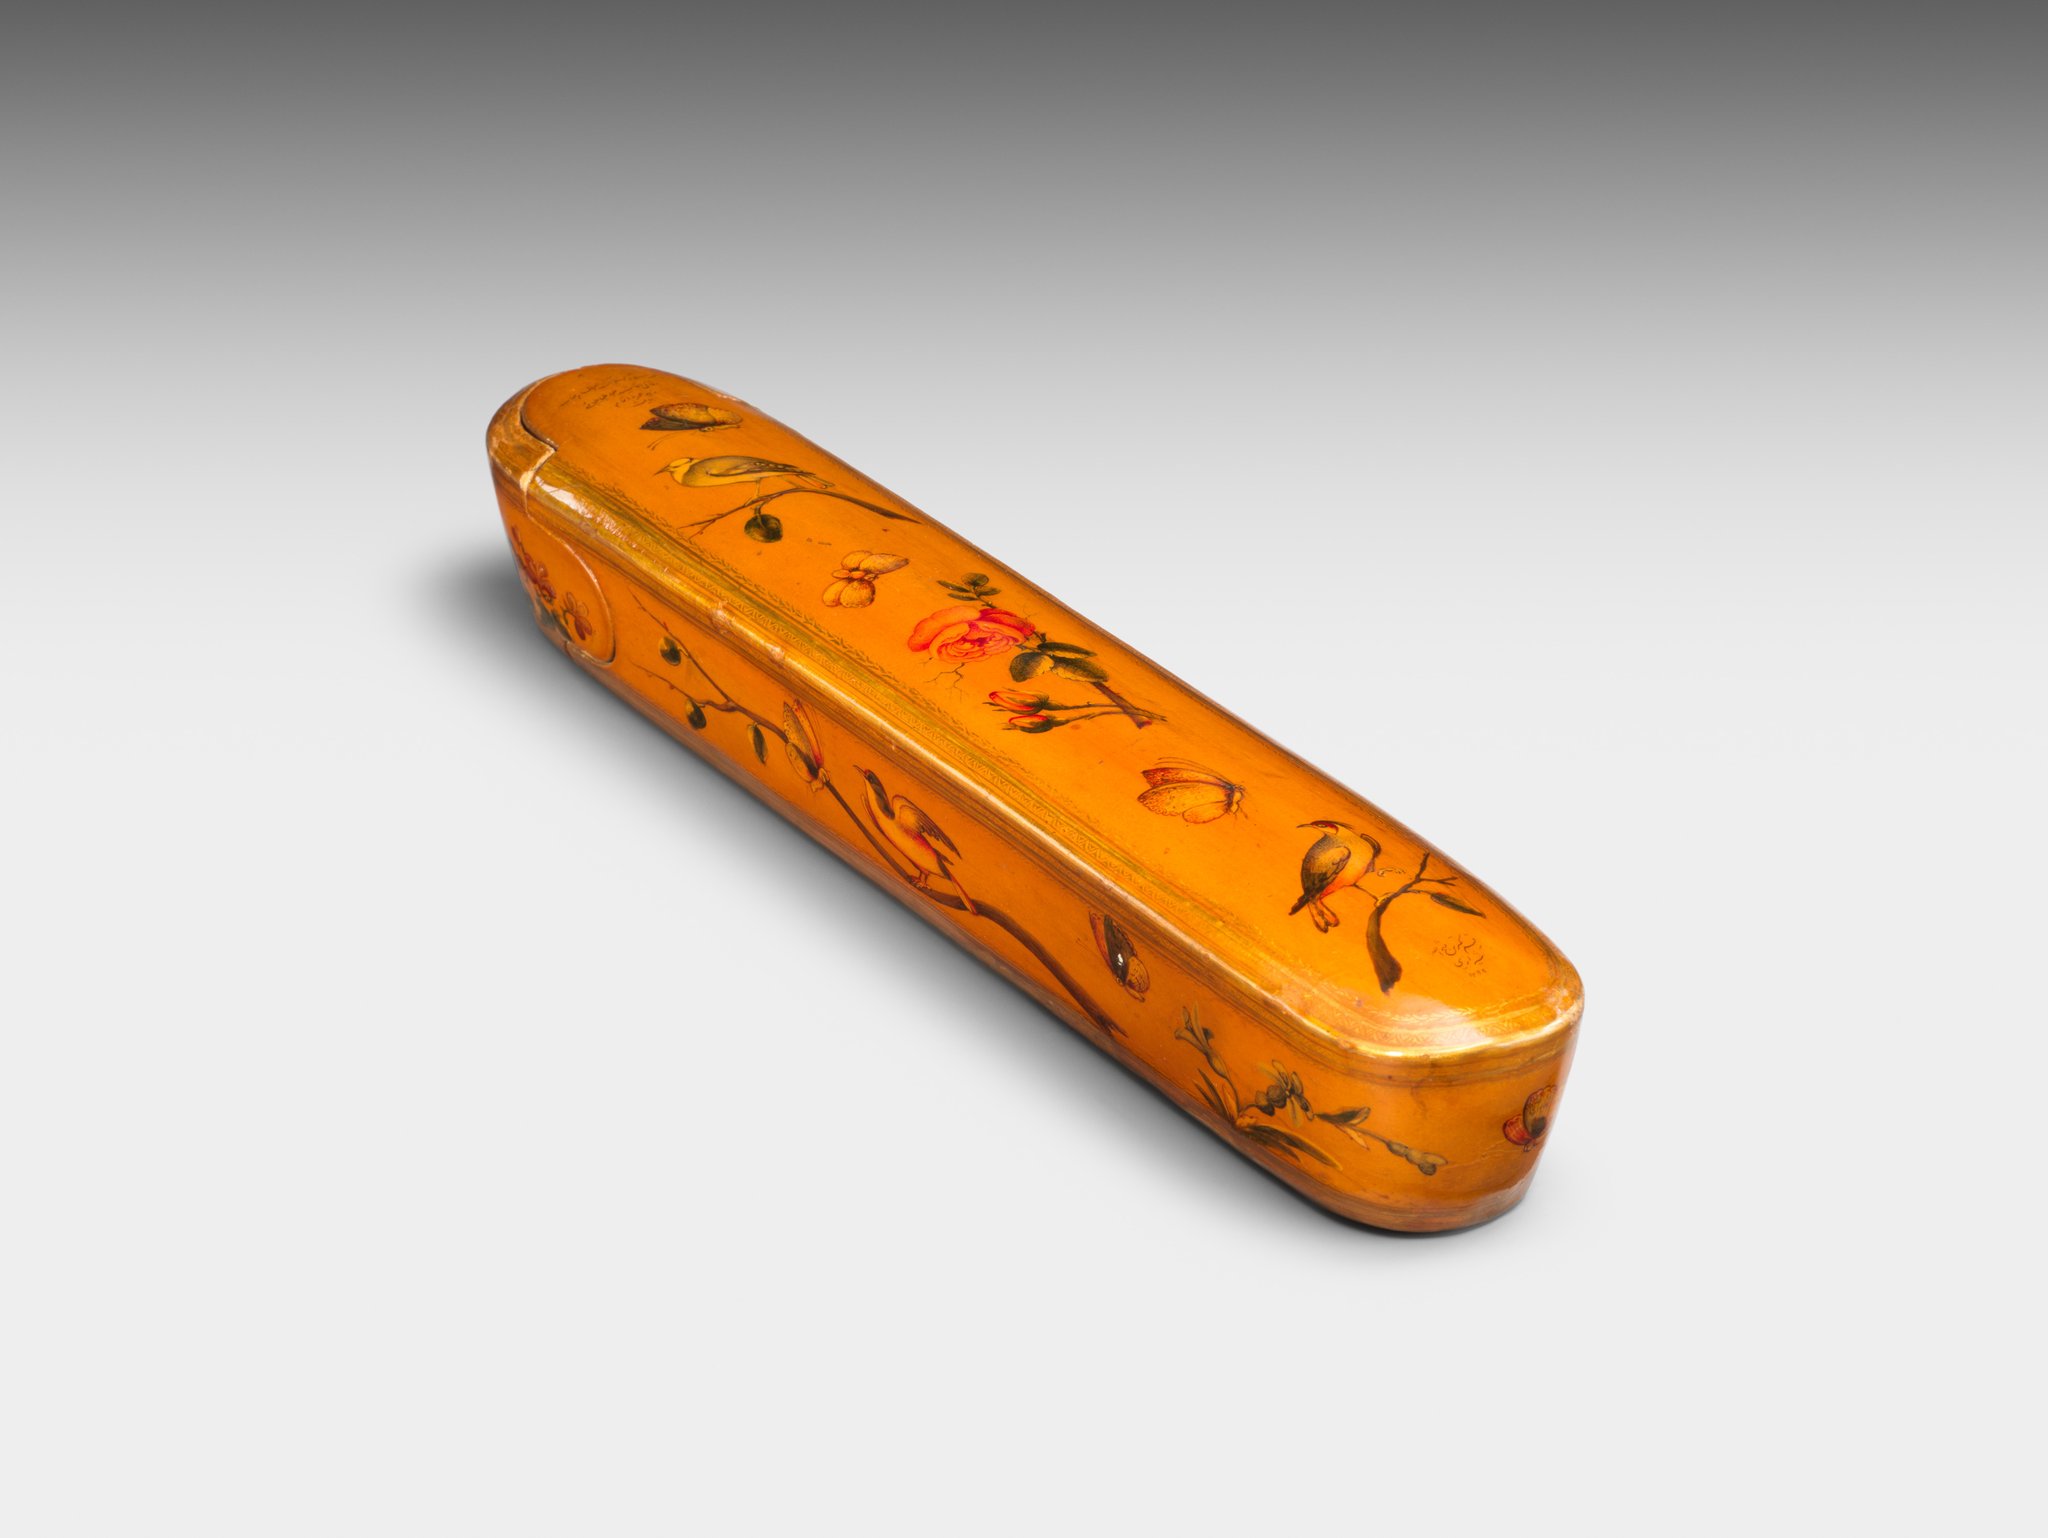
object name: pen box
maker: fathallah shirazi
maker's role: artist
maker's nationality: iranian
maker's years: 1825-1905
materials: paper, varnish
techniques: gilding, painting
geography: iran